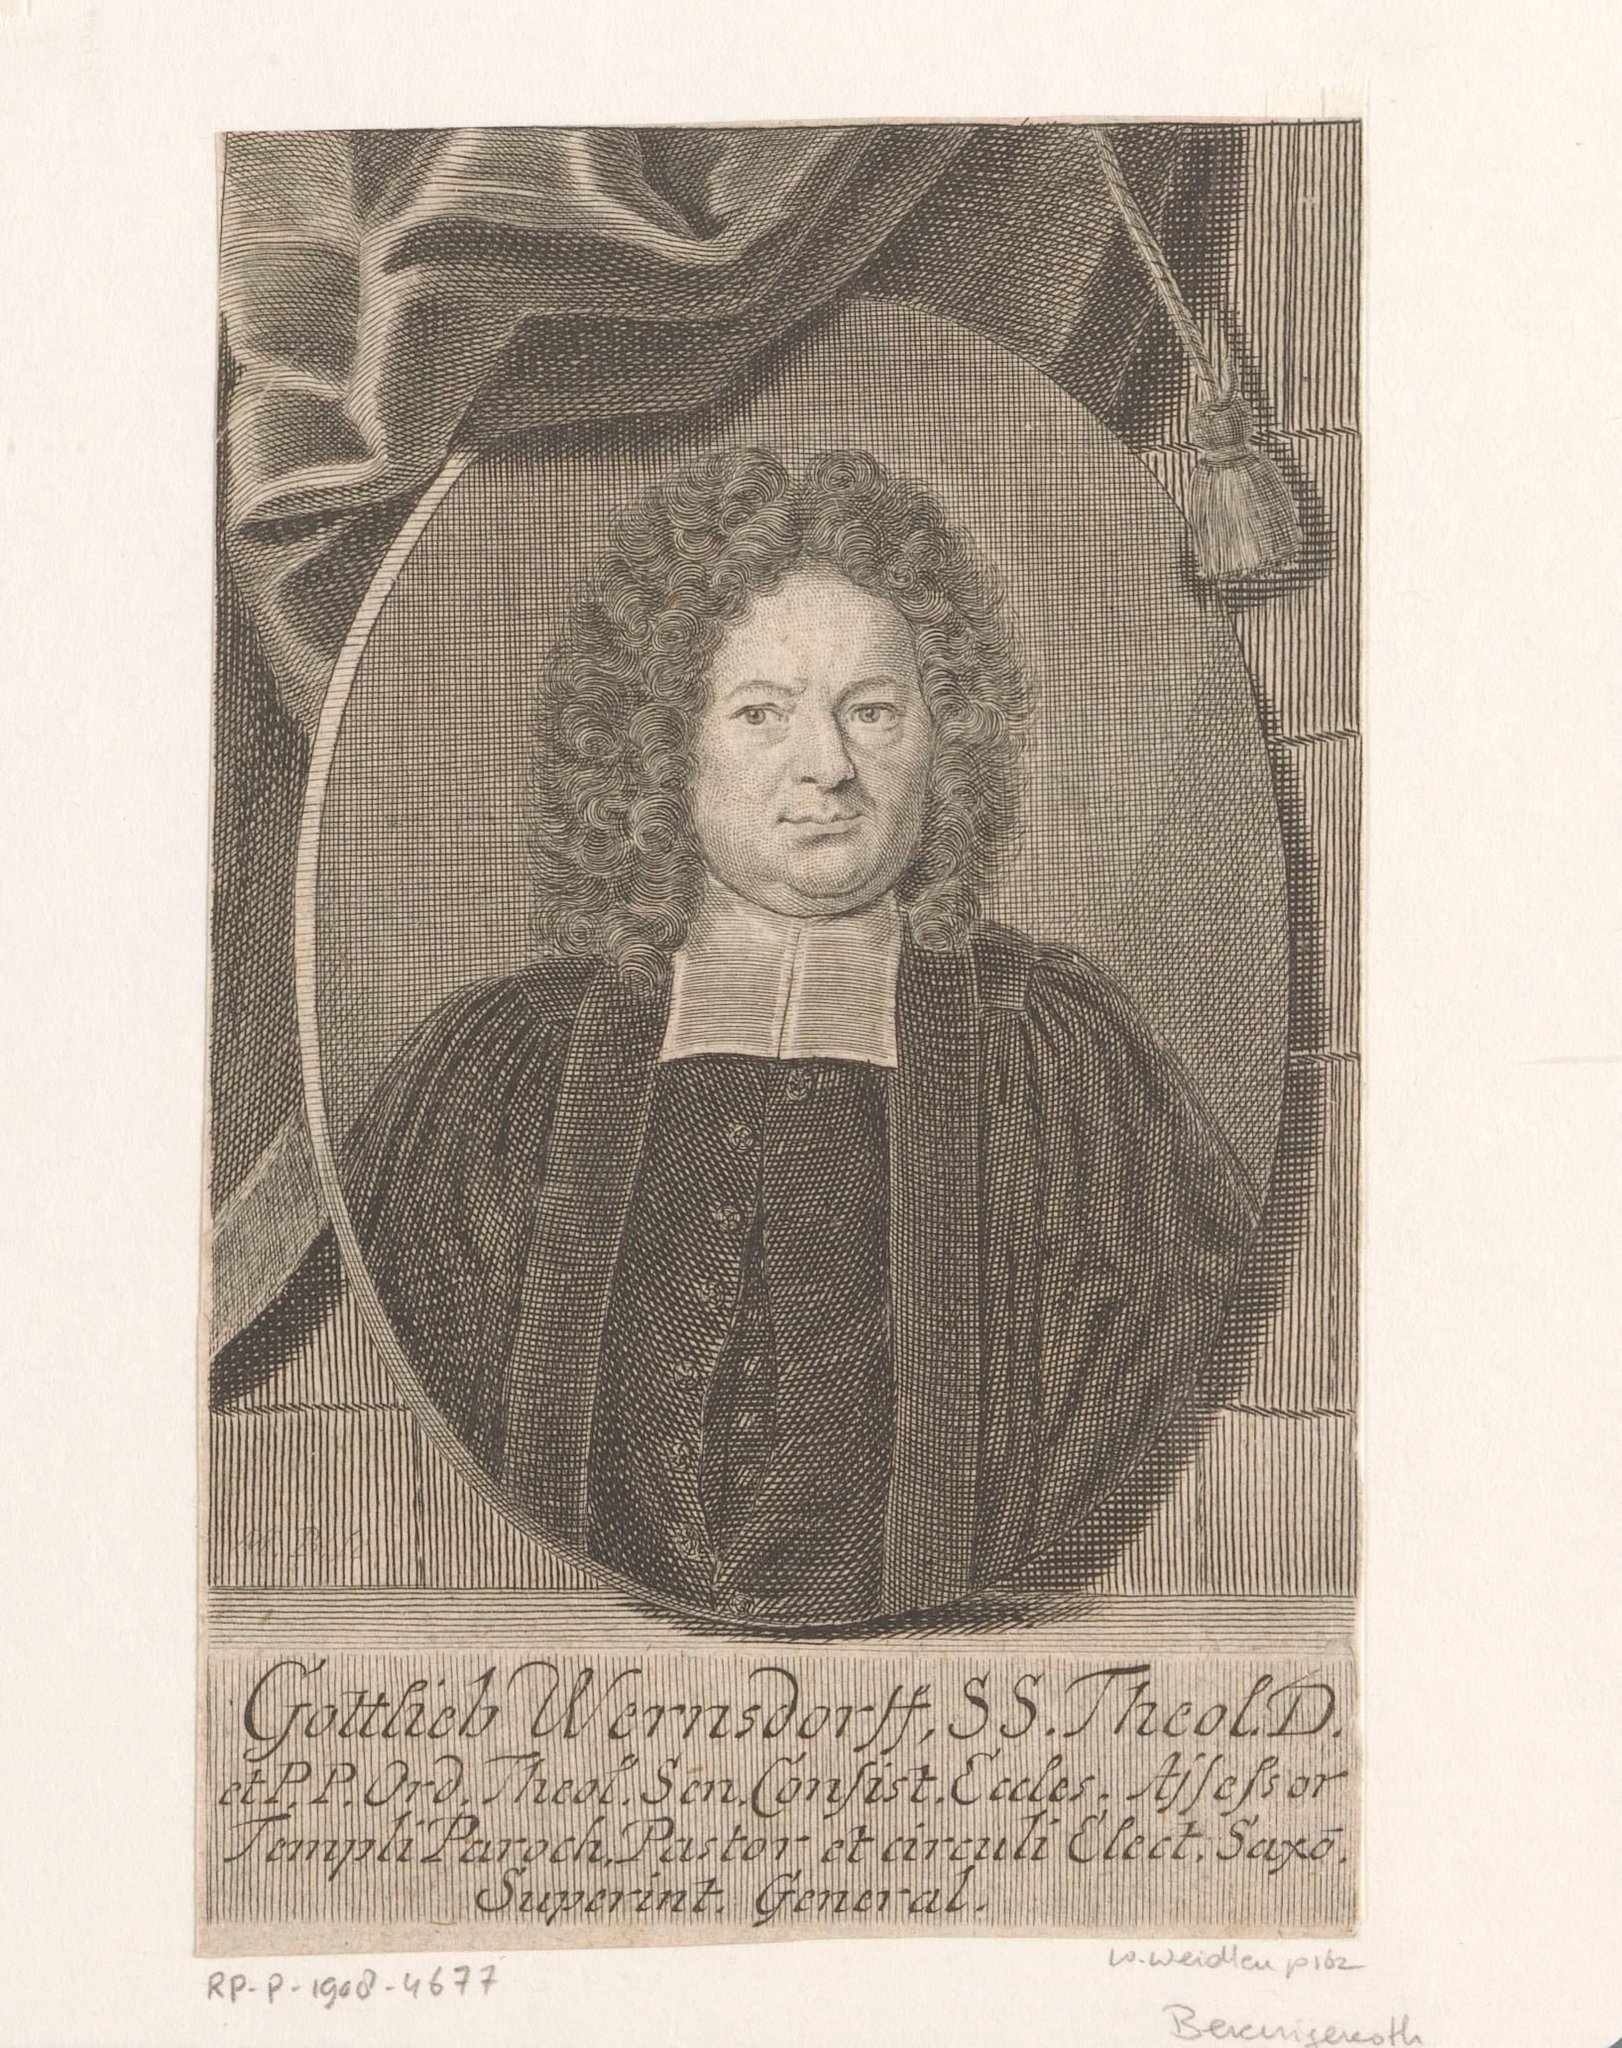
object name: print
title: Portret van Gottlieb Wernsdorf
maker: martin bernigeroth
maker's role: print maker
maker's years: 1670-1733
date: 1719-1733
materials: paper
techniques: engraving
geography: leipzig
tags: gottlieb wernsdorff, historical persons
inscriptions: collector's mark: Lugt 2228